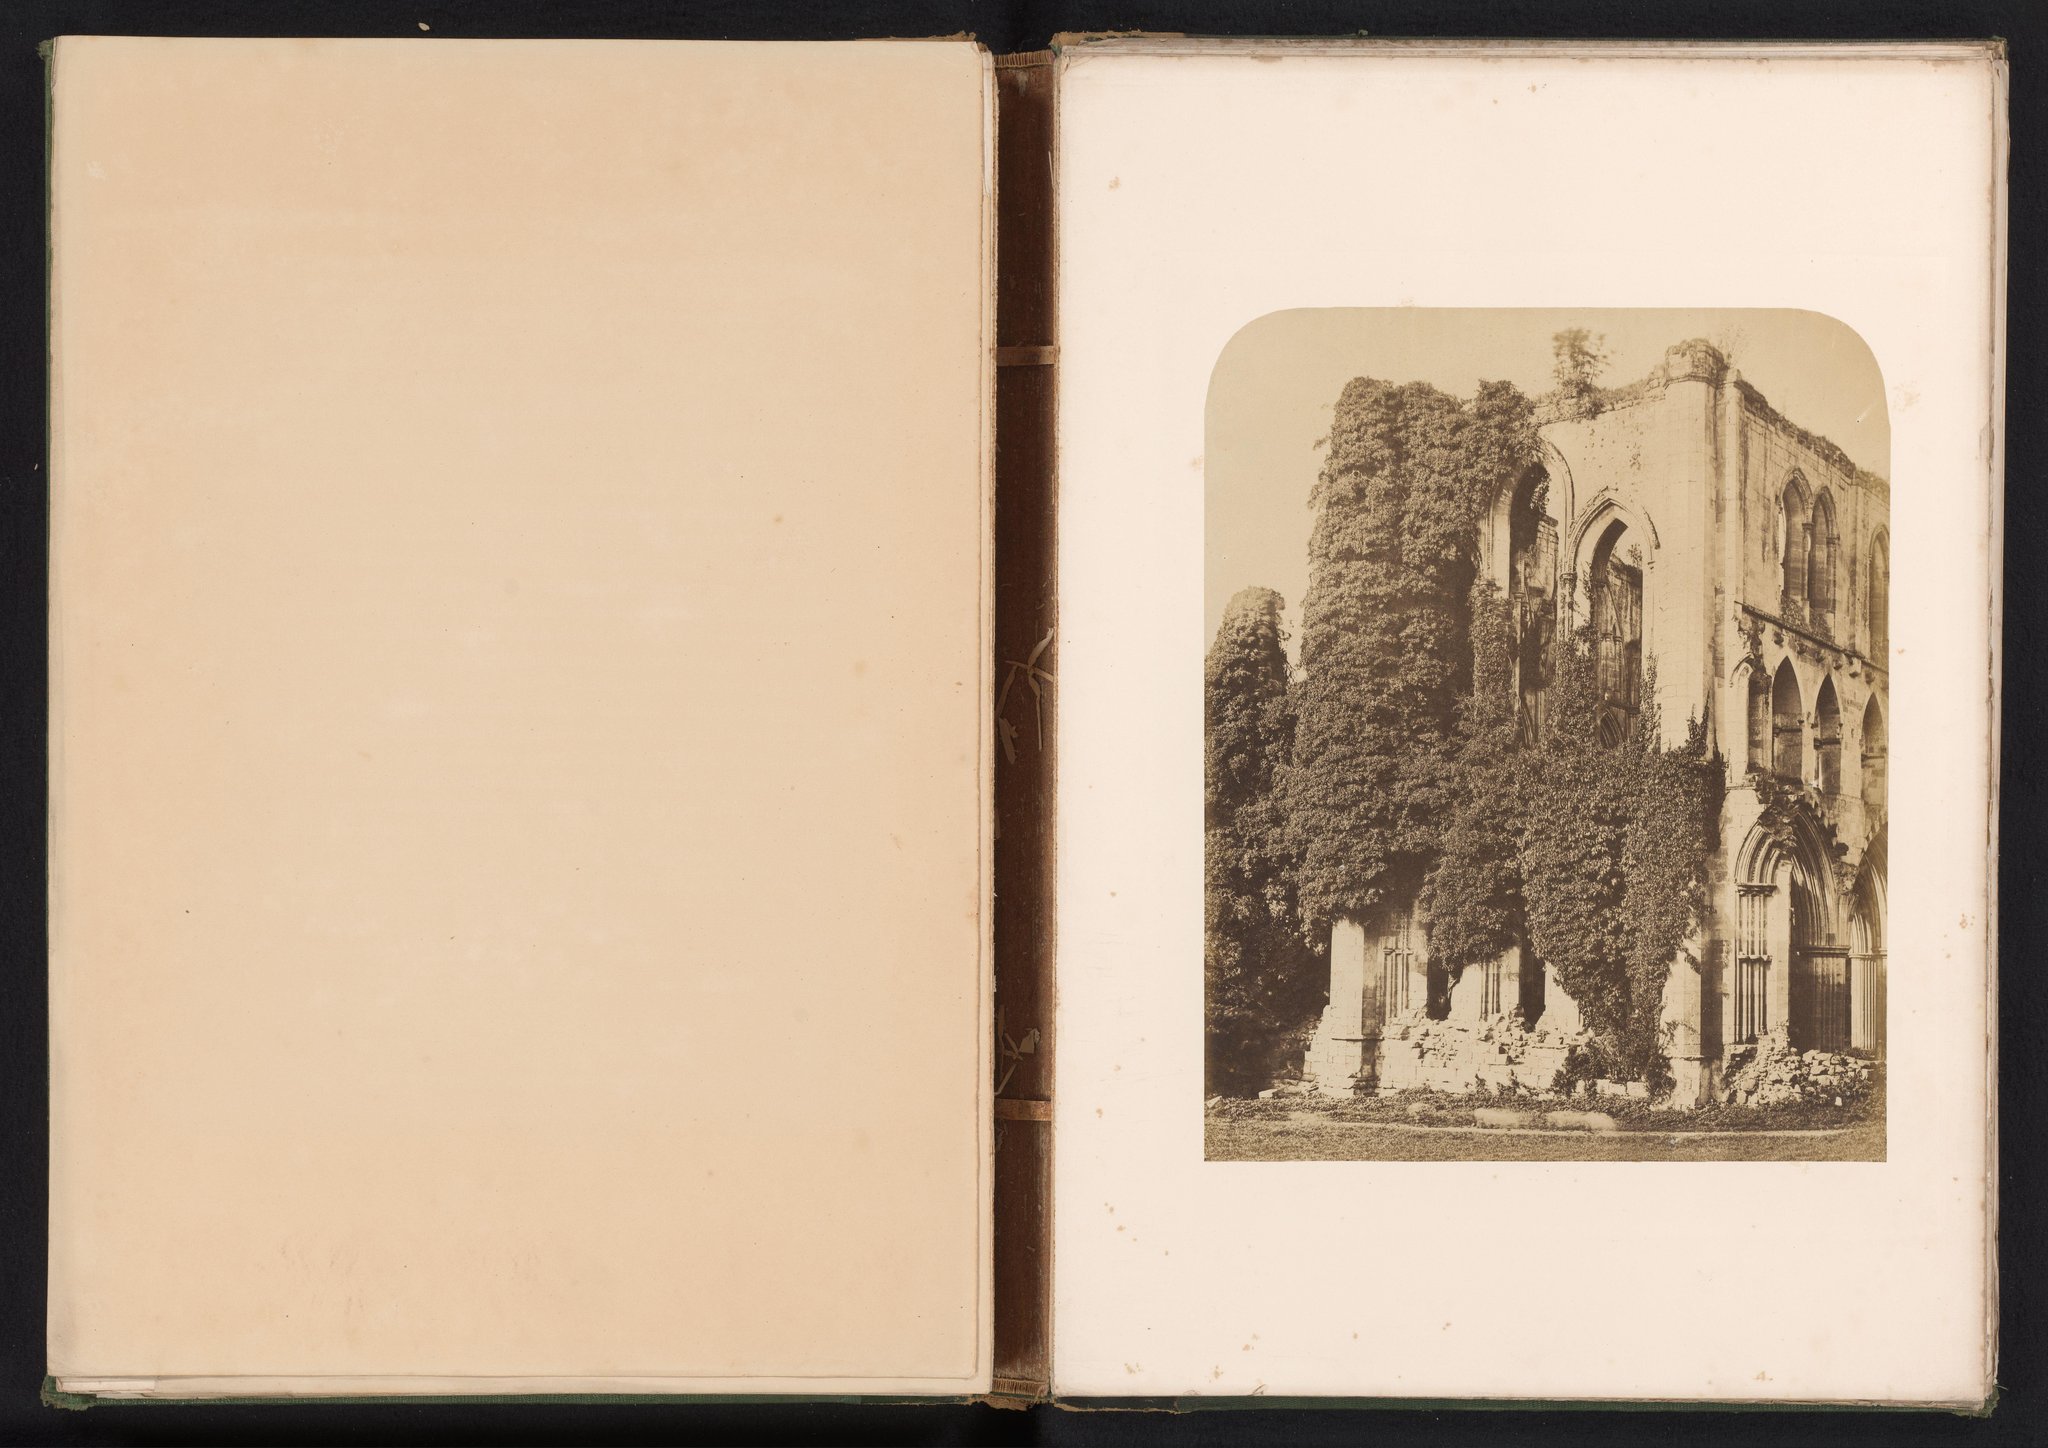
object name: photograph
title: Zuidzijde van de Abdij van Rievaulx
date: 1851-1856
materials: photographic support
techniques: albumen print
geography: yorkshire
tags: landscape with ruins, ruin of church, monastery, etc.